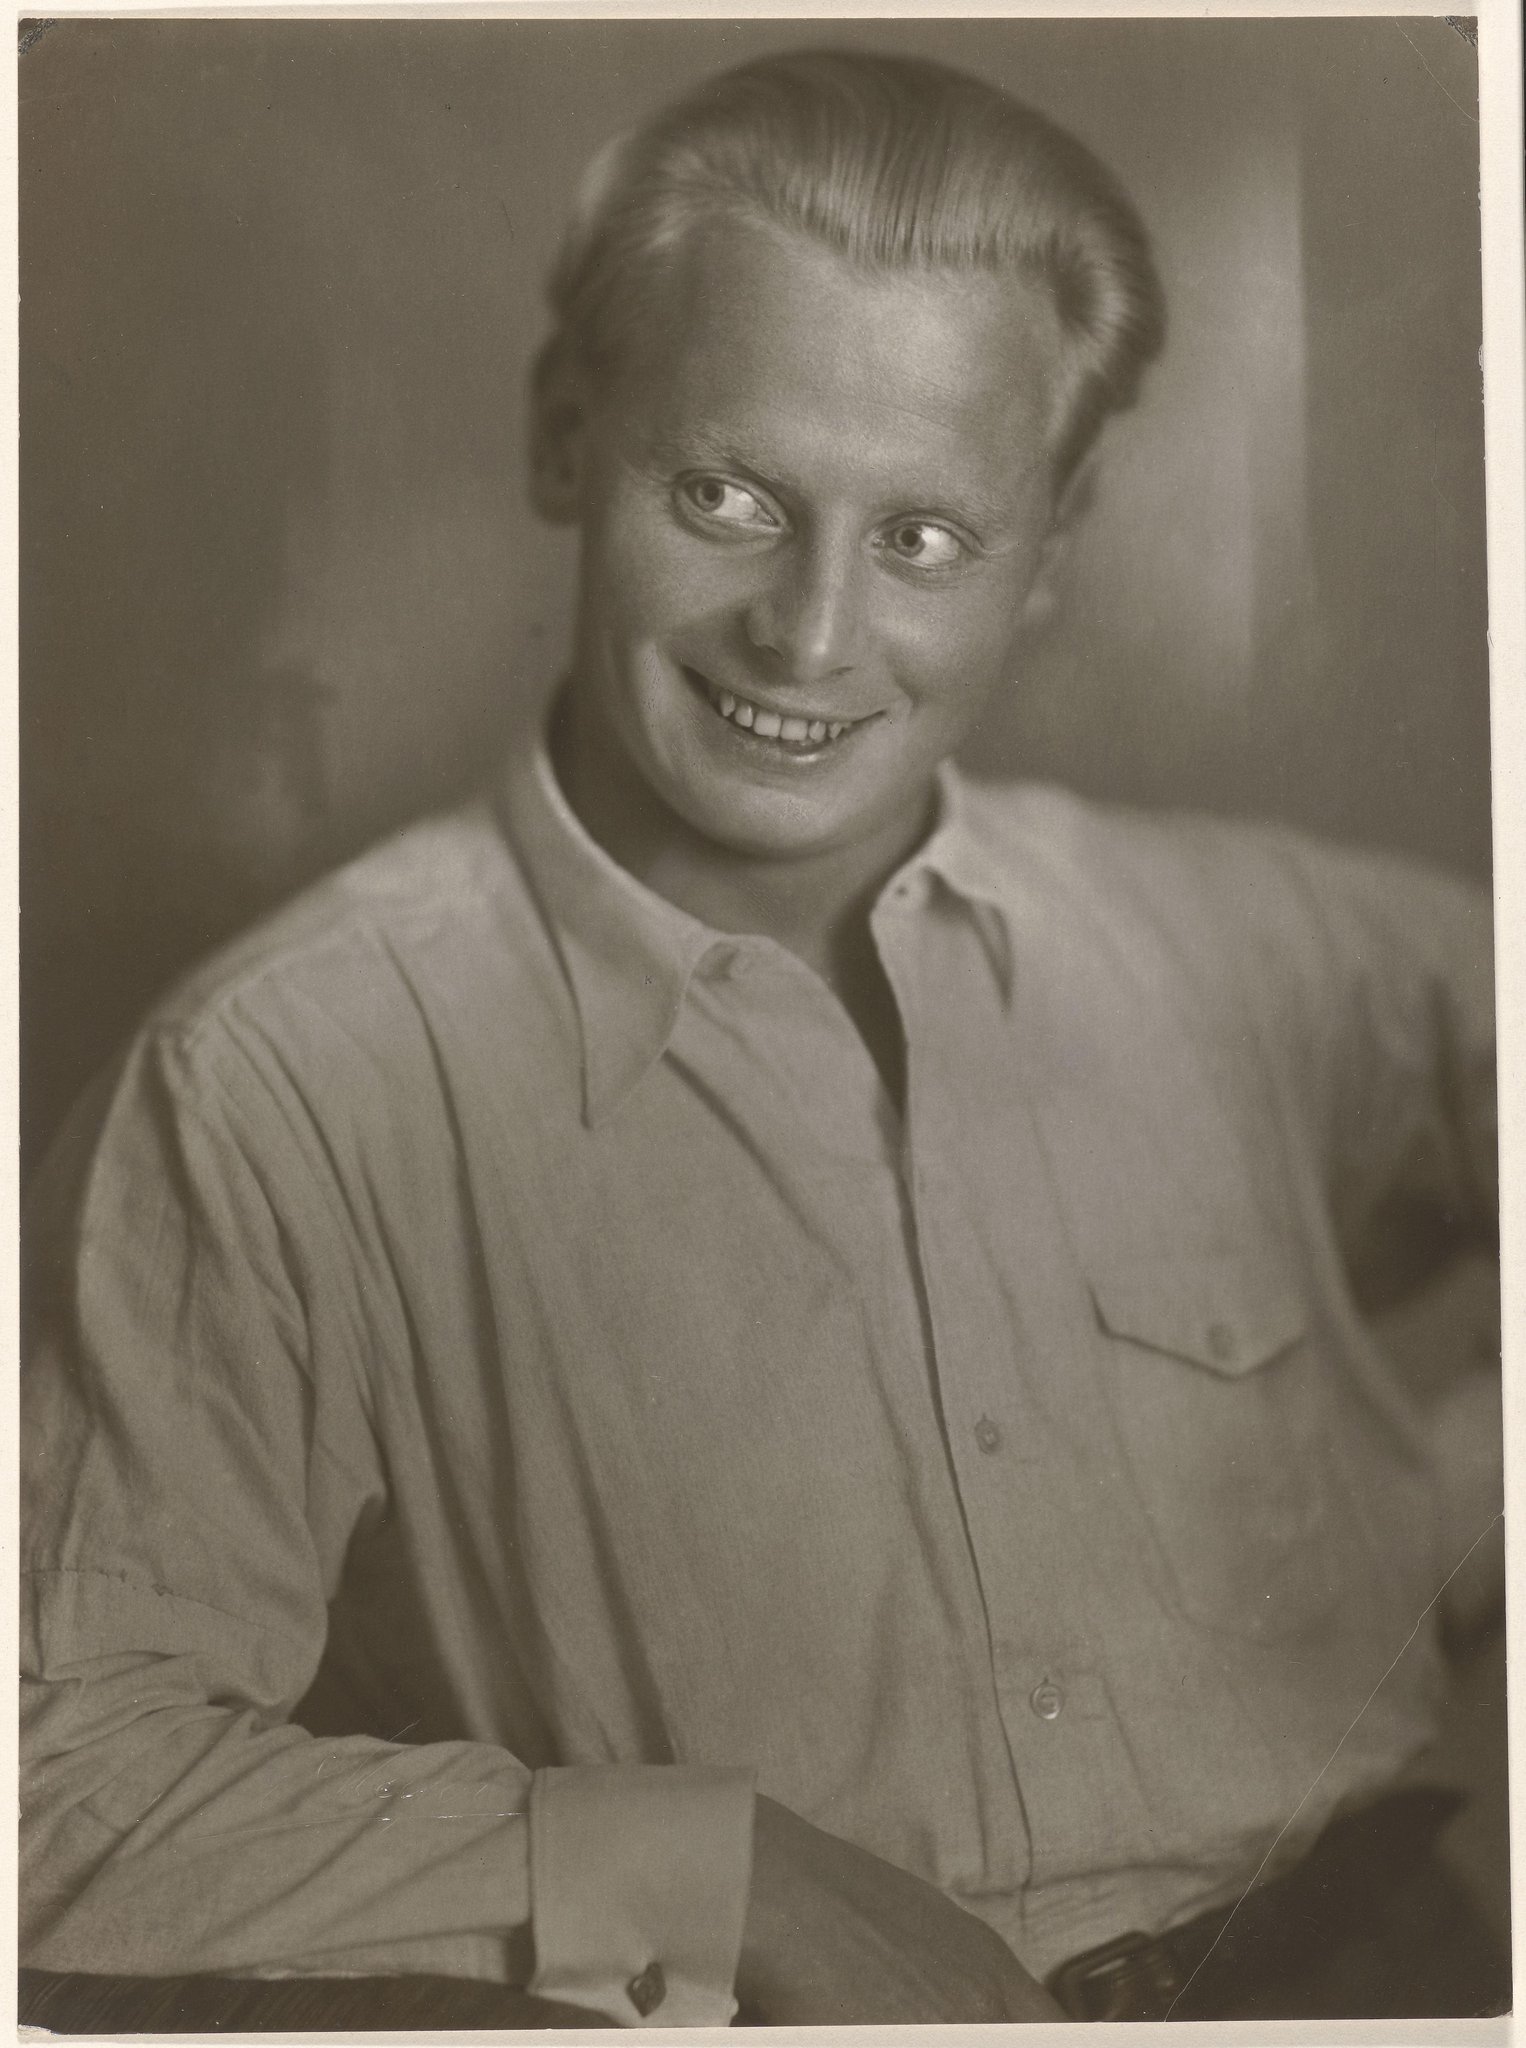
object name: photograph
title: Portret van Hans W. Harlaft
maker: hugo julius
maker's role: fotograaf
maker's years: 1870-1949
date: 1900-1940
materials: photographic support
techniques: gelatin silver print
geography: hannover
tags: hannover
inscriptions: check stamp: ‘Albert Meyer Hannover’